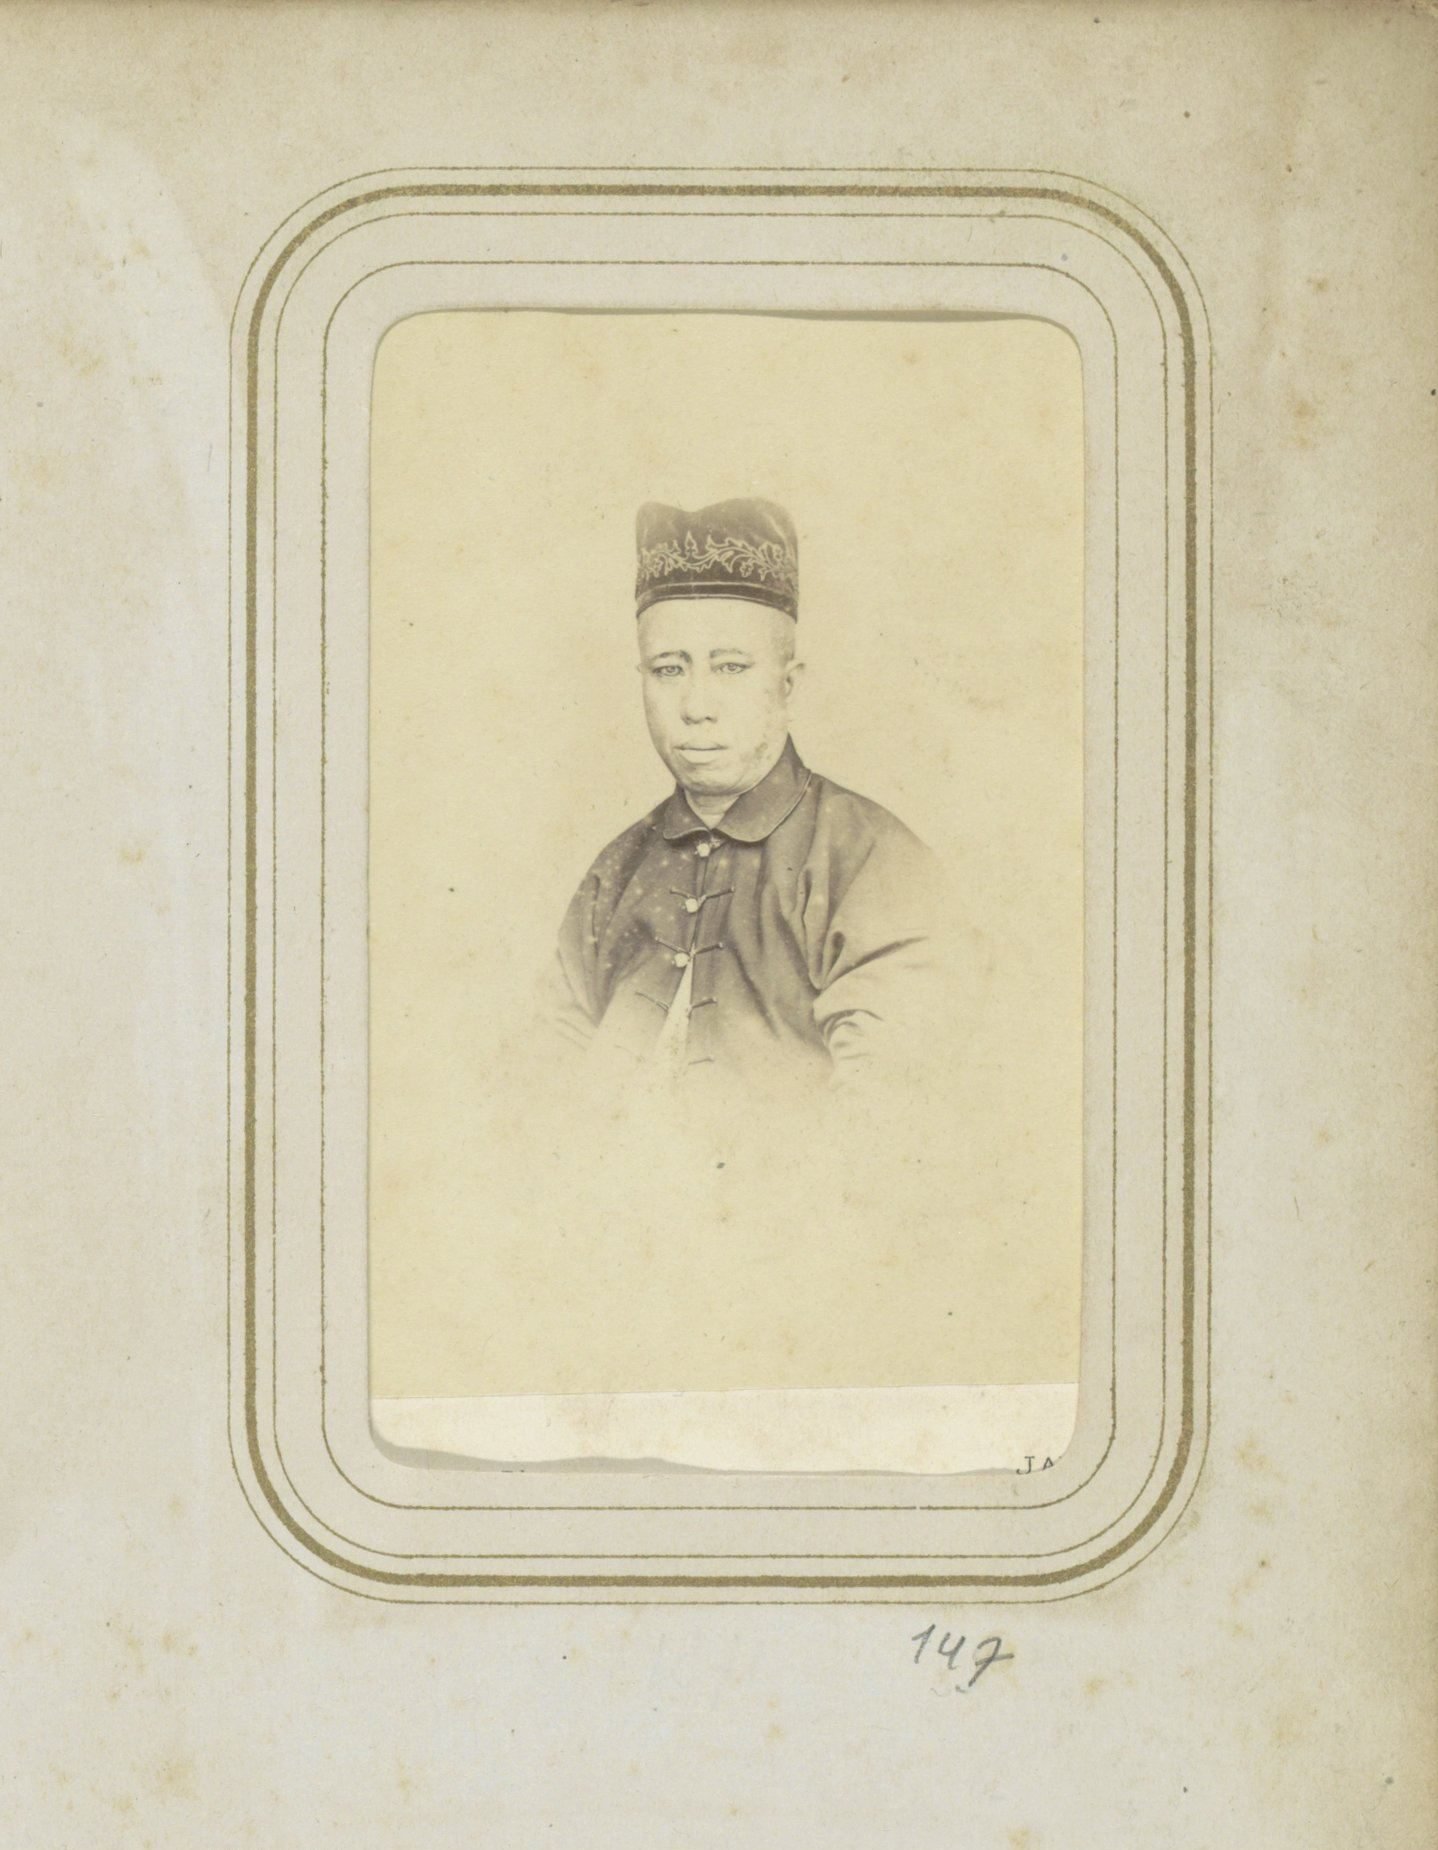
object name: carte de visite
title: Portret van een man in een jas met een hoofddeksel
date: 1857-1880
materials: cardboard, photographic support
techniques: albumen print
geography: java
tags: studio requisites ~ photographer, head-gear, historical persons, clothing for the upper part of the body, family, relationship, descent, coat, cape, java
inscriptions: address: ‘Java’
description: Onderdeel van Familiealbum van H.W.F. Ligtenberg en L.M. Swart met 149 foto's en cartes-de-visite.